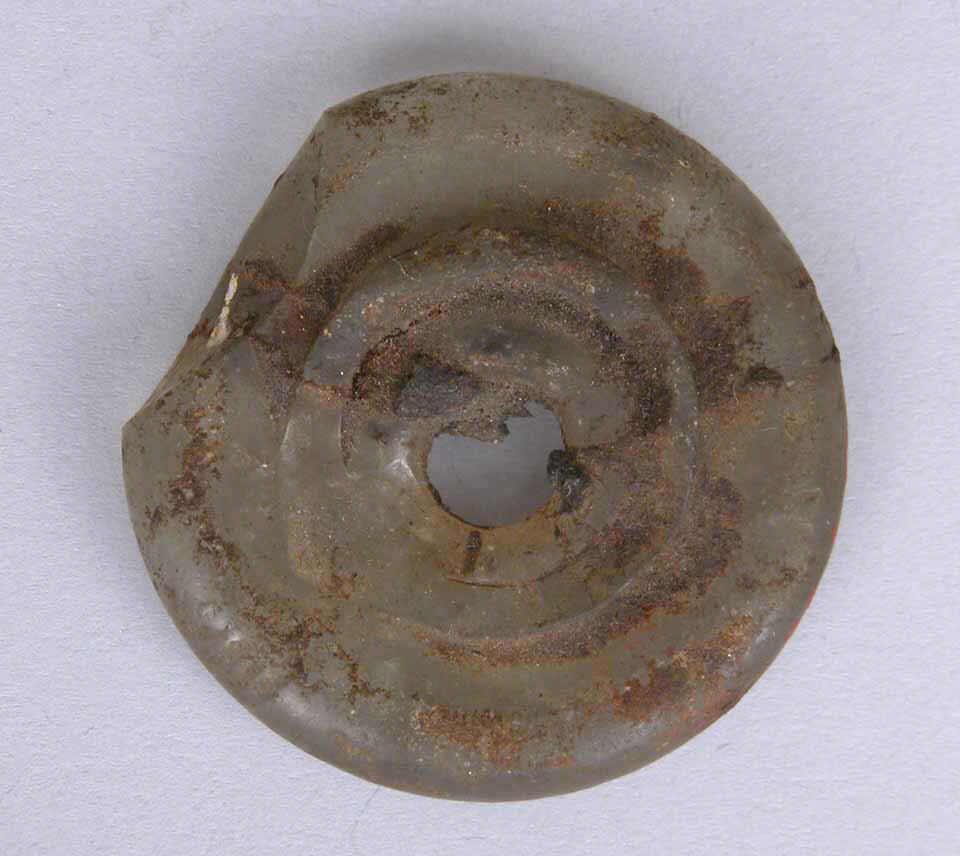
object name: pendant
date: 201-1200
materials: glass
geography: egypt